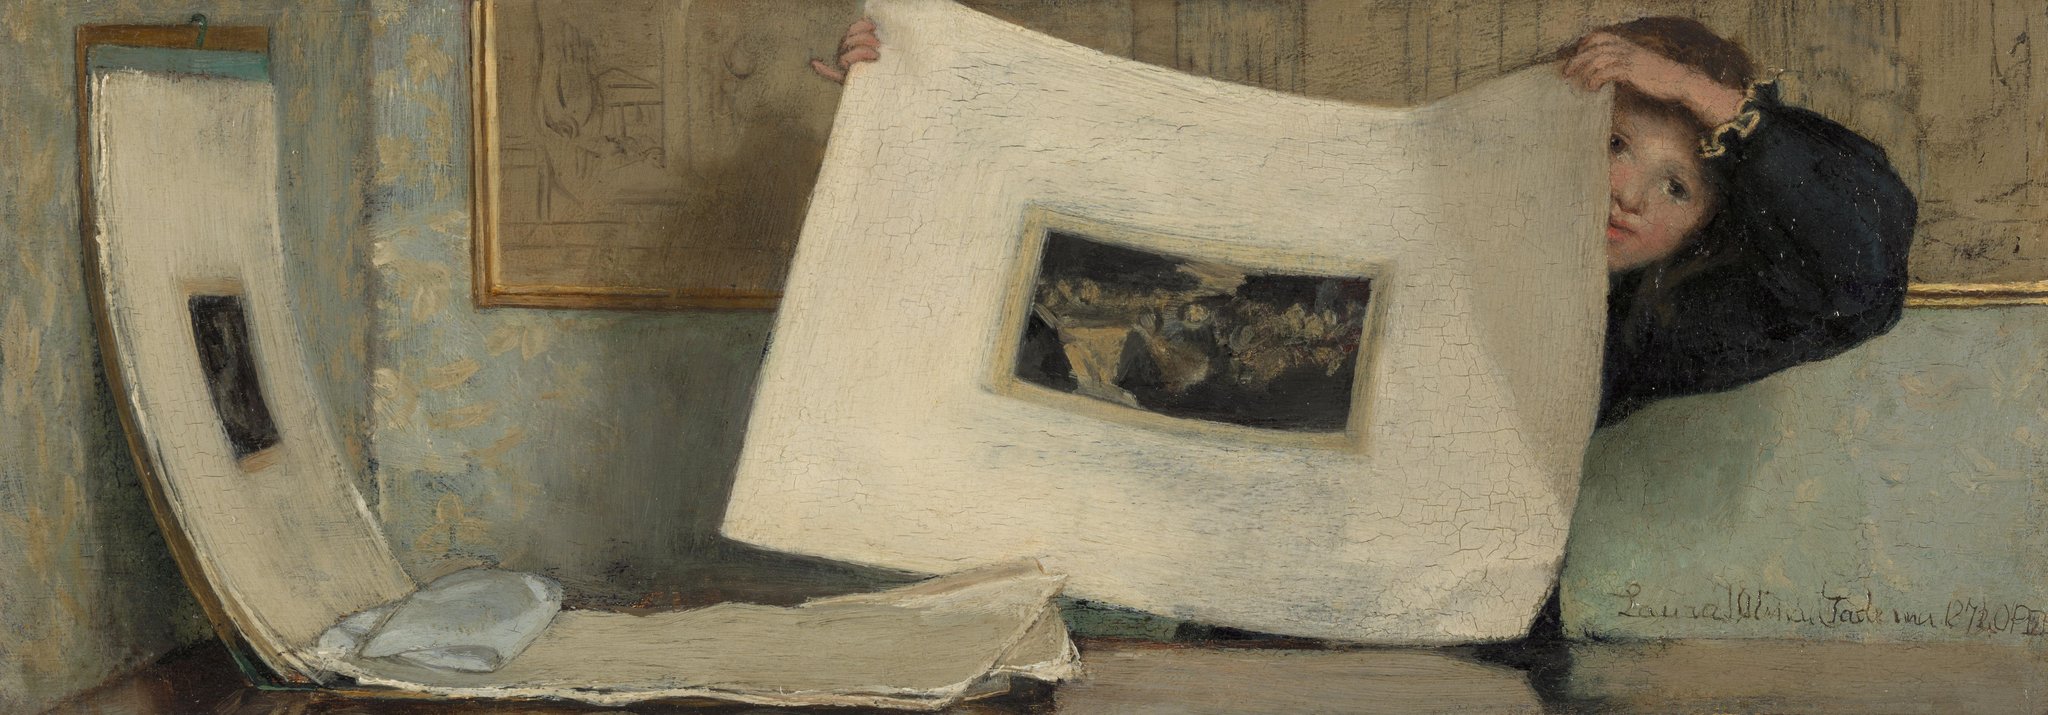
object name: painting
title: Anna Leafing Through a Portfolio of Prints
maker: laura theresa alma tadema (lady)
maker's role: painter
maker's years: 1852-1909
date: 1874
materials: oil, paint, panel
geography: london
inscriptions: signature and date: ‘Laura Alma Tadema 1874 Op. VI.’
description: Anna, the painter’s seven-year-old stepdaughter, holds up a print with both hands. She has to peer around the sheet; that is how large it is, or conversely just how small Anna is. The Alma Tadema family filled their house with portraits of themselves. Possibly this small painting was among them. It affords the viewer an intimate glimpse into the child’s world while simultaneously demonstrating a fondness for graphic art.